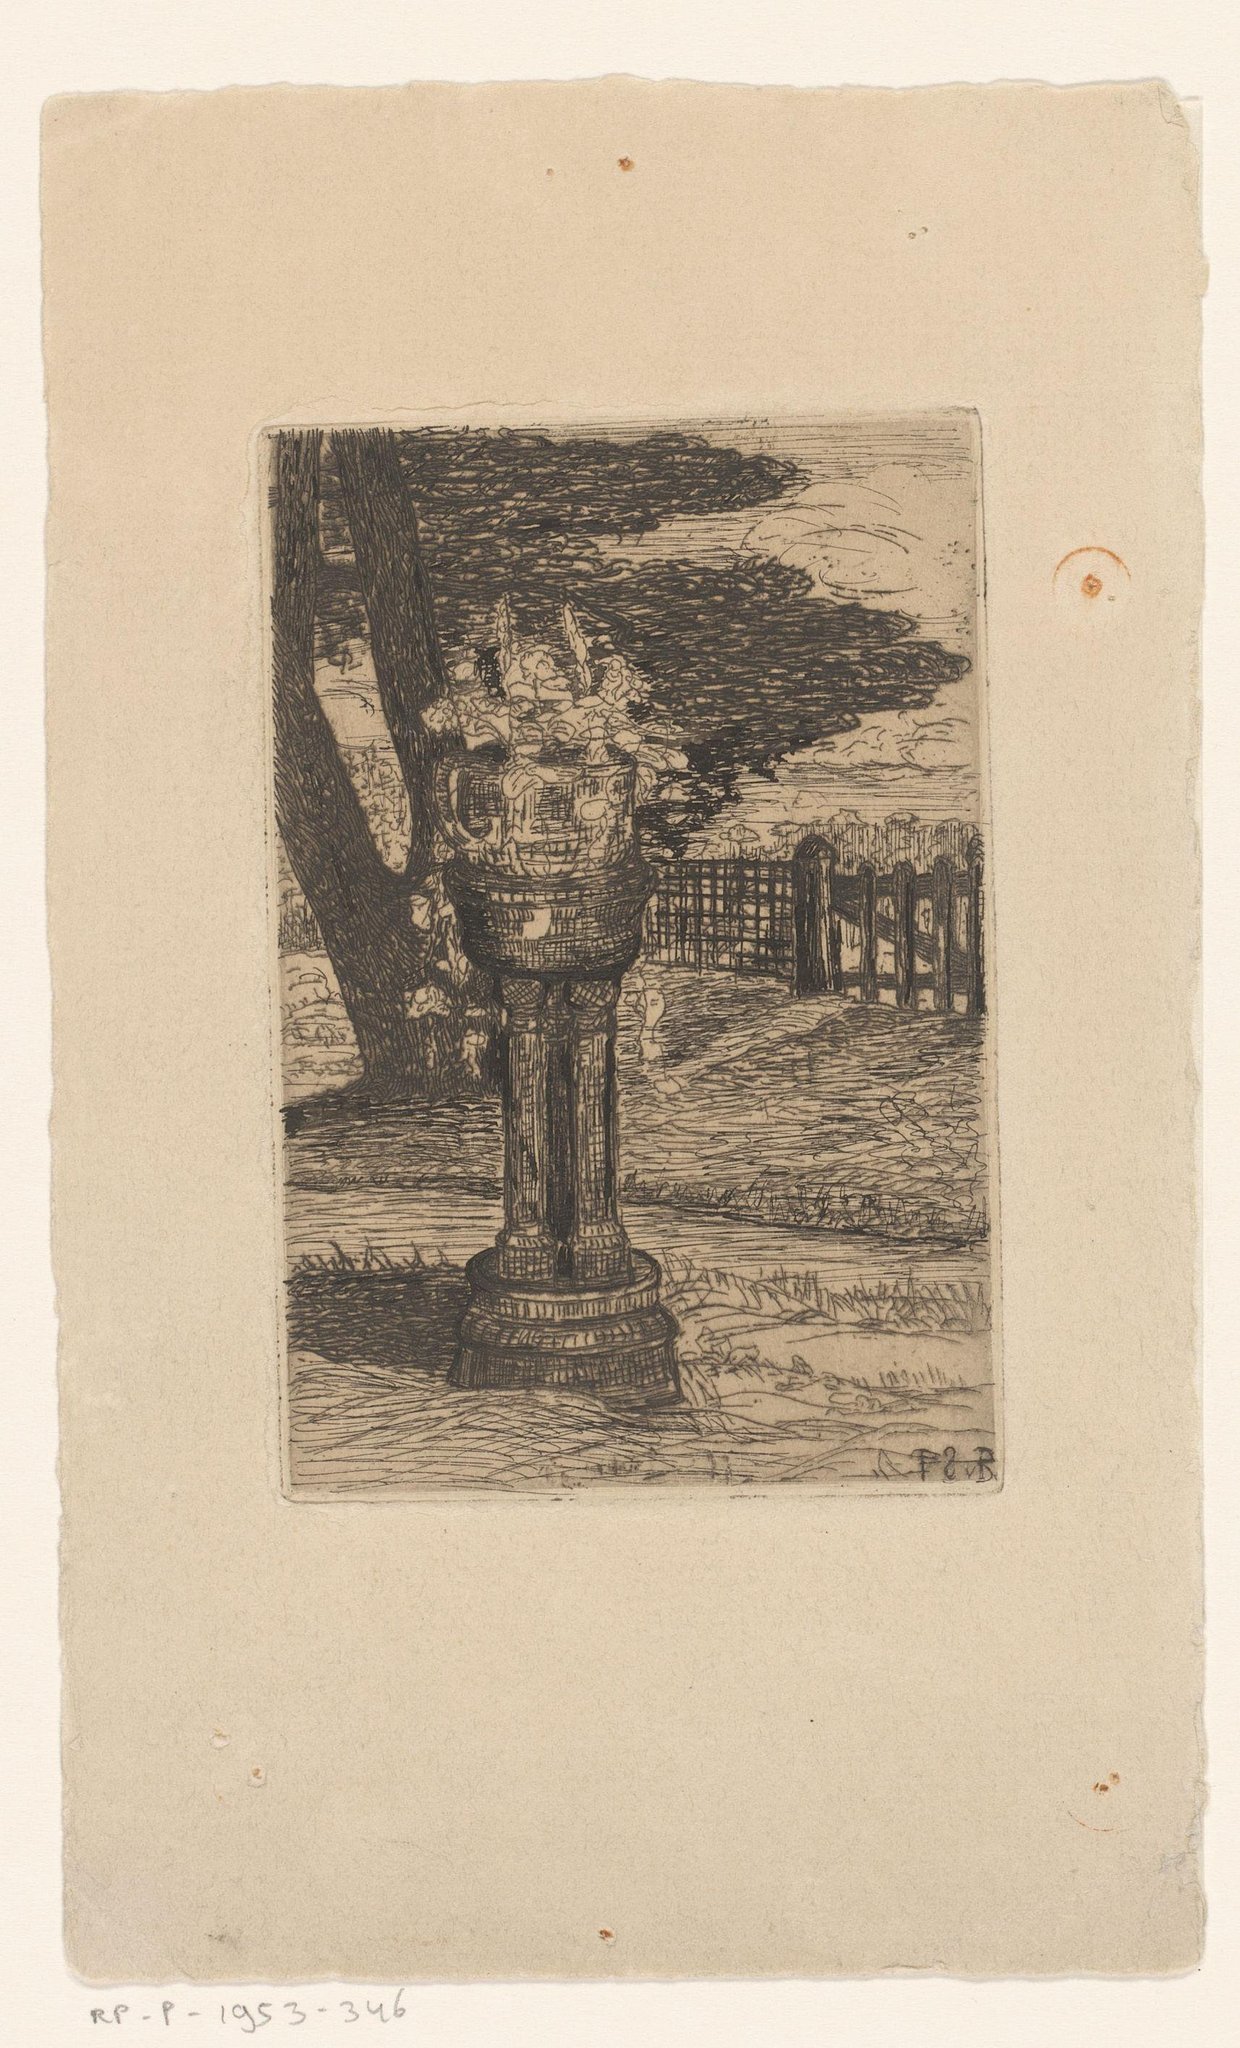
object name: print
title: Tuinvaas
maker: theodora jacoba van bosse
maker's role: print maker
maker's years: 1874-1953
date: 1899-1953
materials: paper, ink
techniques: drypoint, etching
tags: garden vase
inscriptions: monogram: ‘JTvB’, collector's mark: Lugt 2228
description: Vaas met een plant op een hoge sokkel in een tuin, rechts een hek.